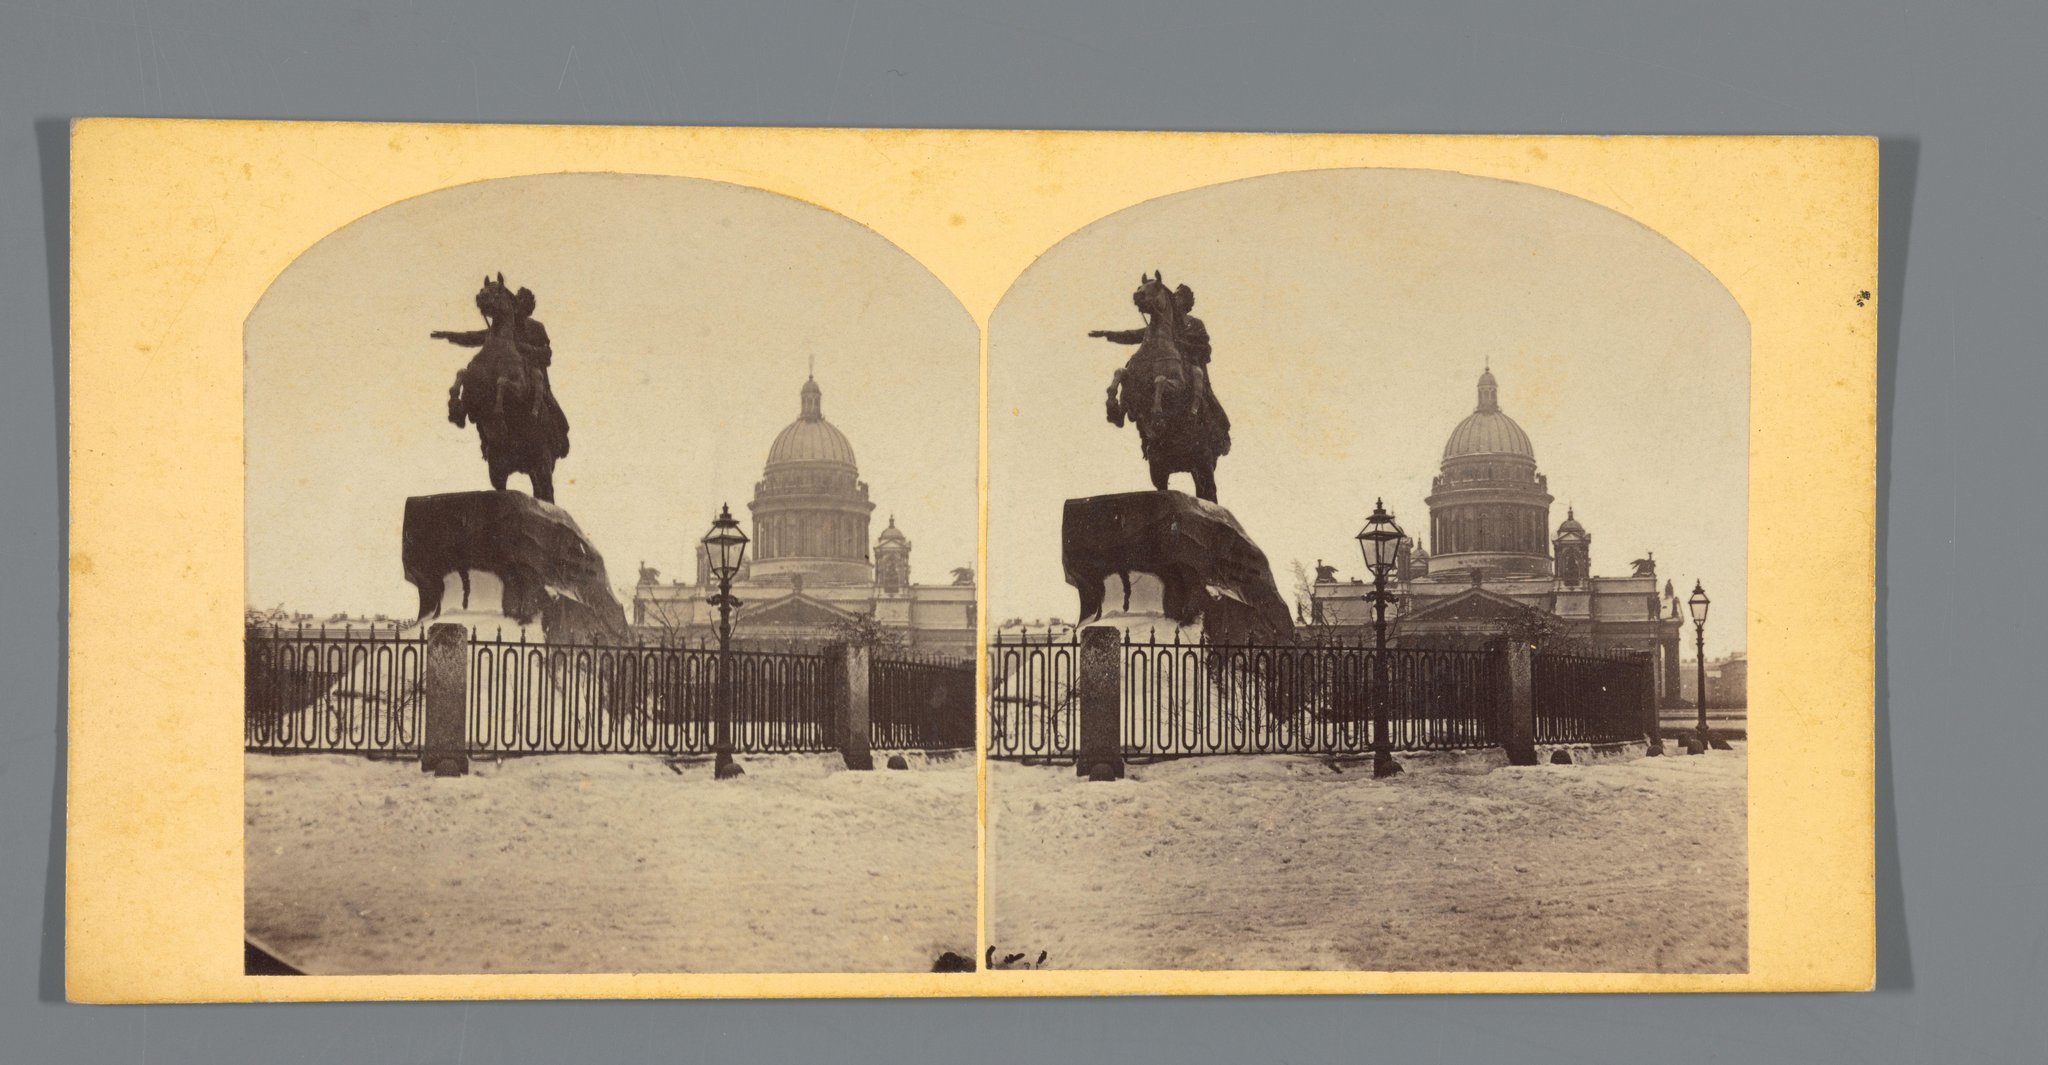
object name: stereograph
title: Standbeeld van Peter de Grote I voor de Izaäkkathedraal in Sint-Petersburg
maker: Anonymous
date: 1850-1880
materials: cardboard, photographic support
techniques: albumen print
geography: sint-petersburg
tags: church (exterior), equestrian statue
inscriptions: inscription: ‘St. Pétersbourg Statue de Pierre le grand’